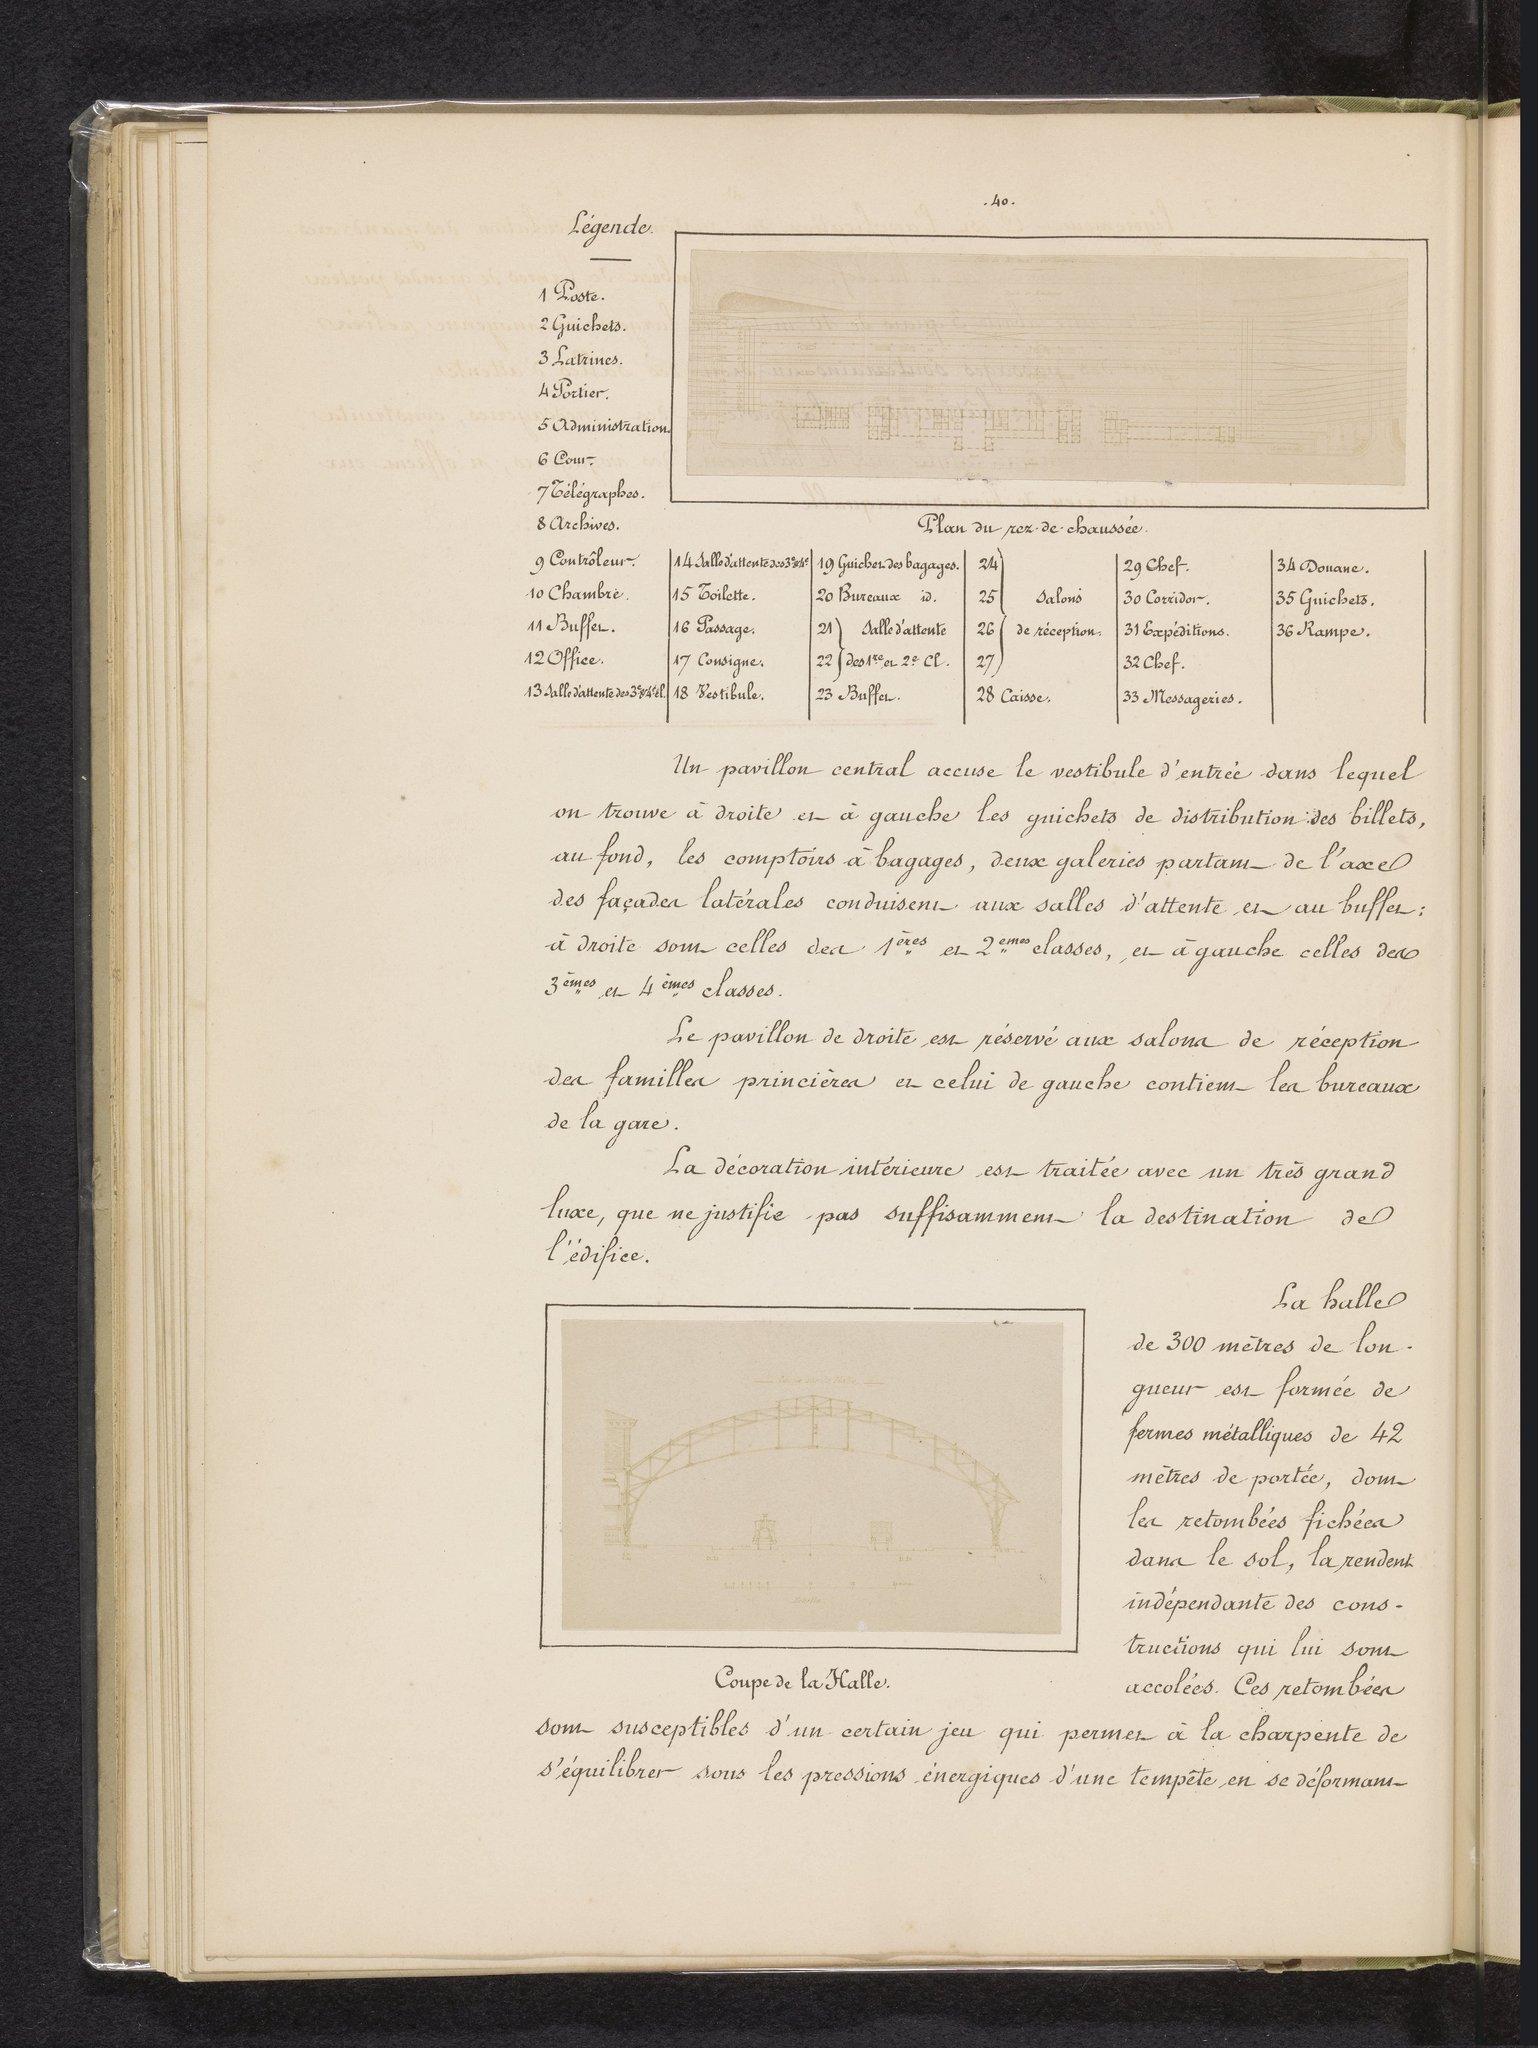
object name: reproduction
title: Coupe de la halle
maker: Anonymous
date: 1874-1884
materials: photographic support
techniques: albumen print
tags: station; shelter (railway, tramway)